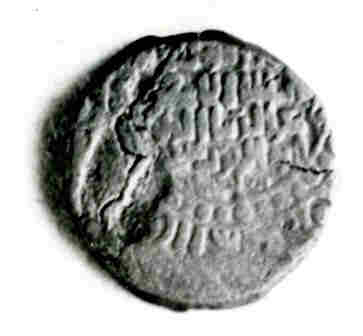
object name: coin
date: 1101-1150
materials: copper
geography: iran